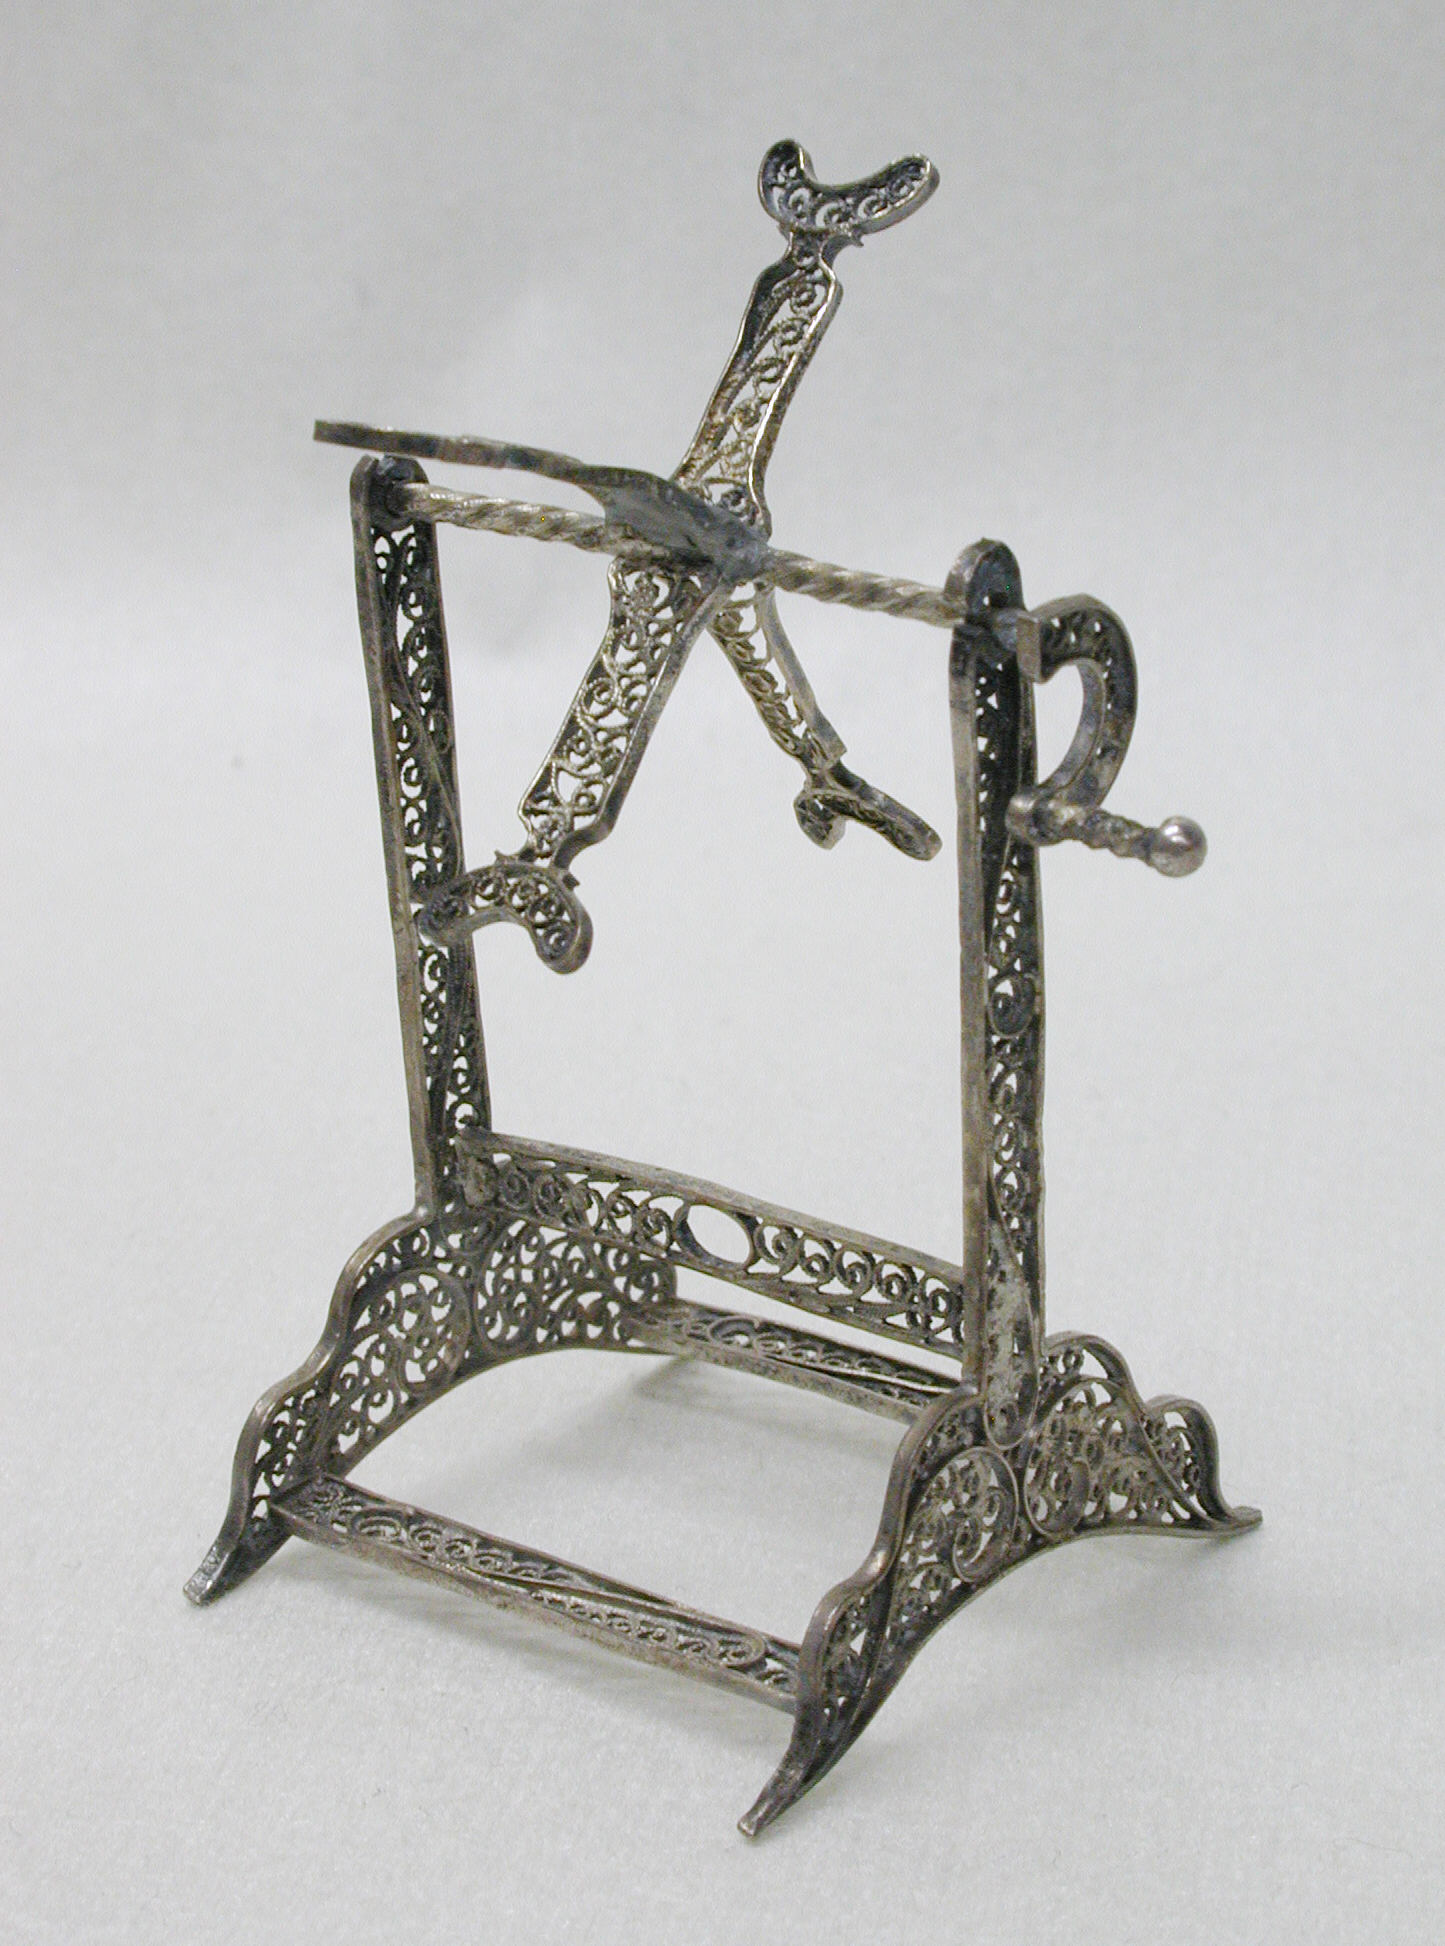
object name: flax reel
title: Miniature flax reel (part of a set)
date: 1675-1700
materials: silver